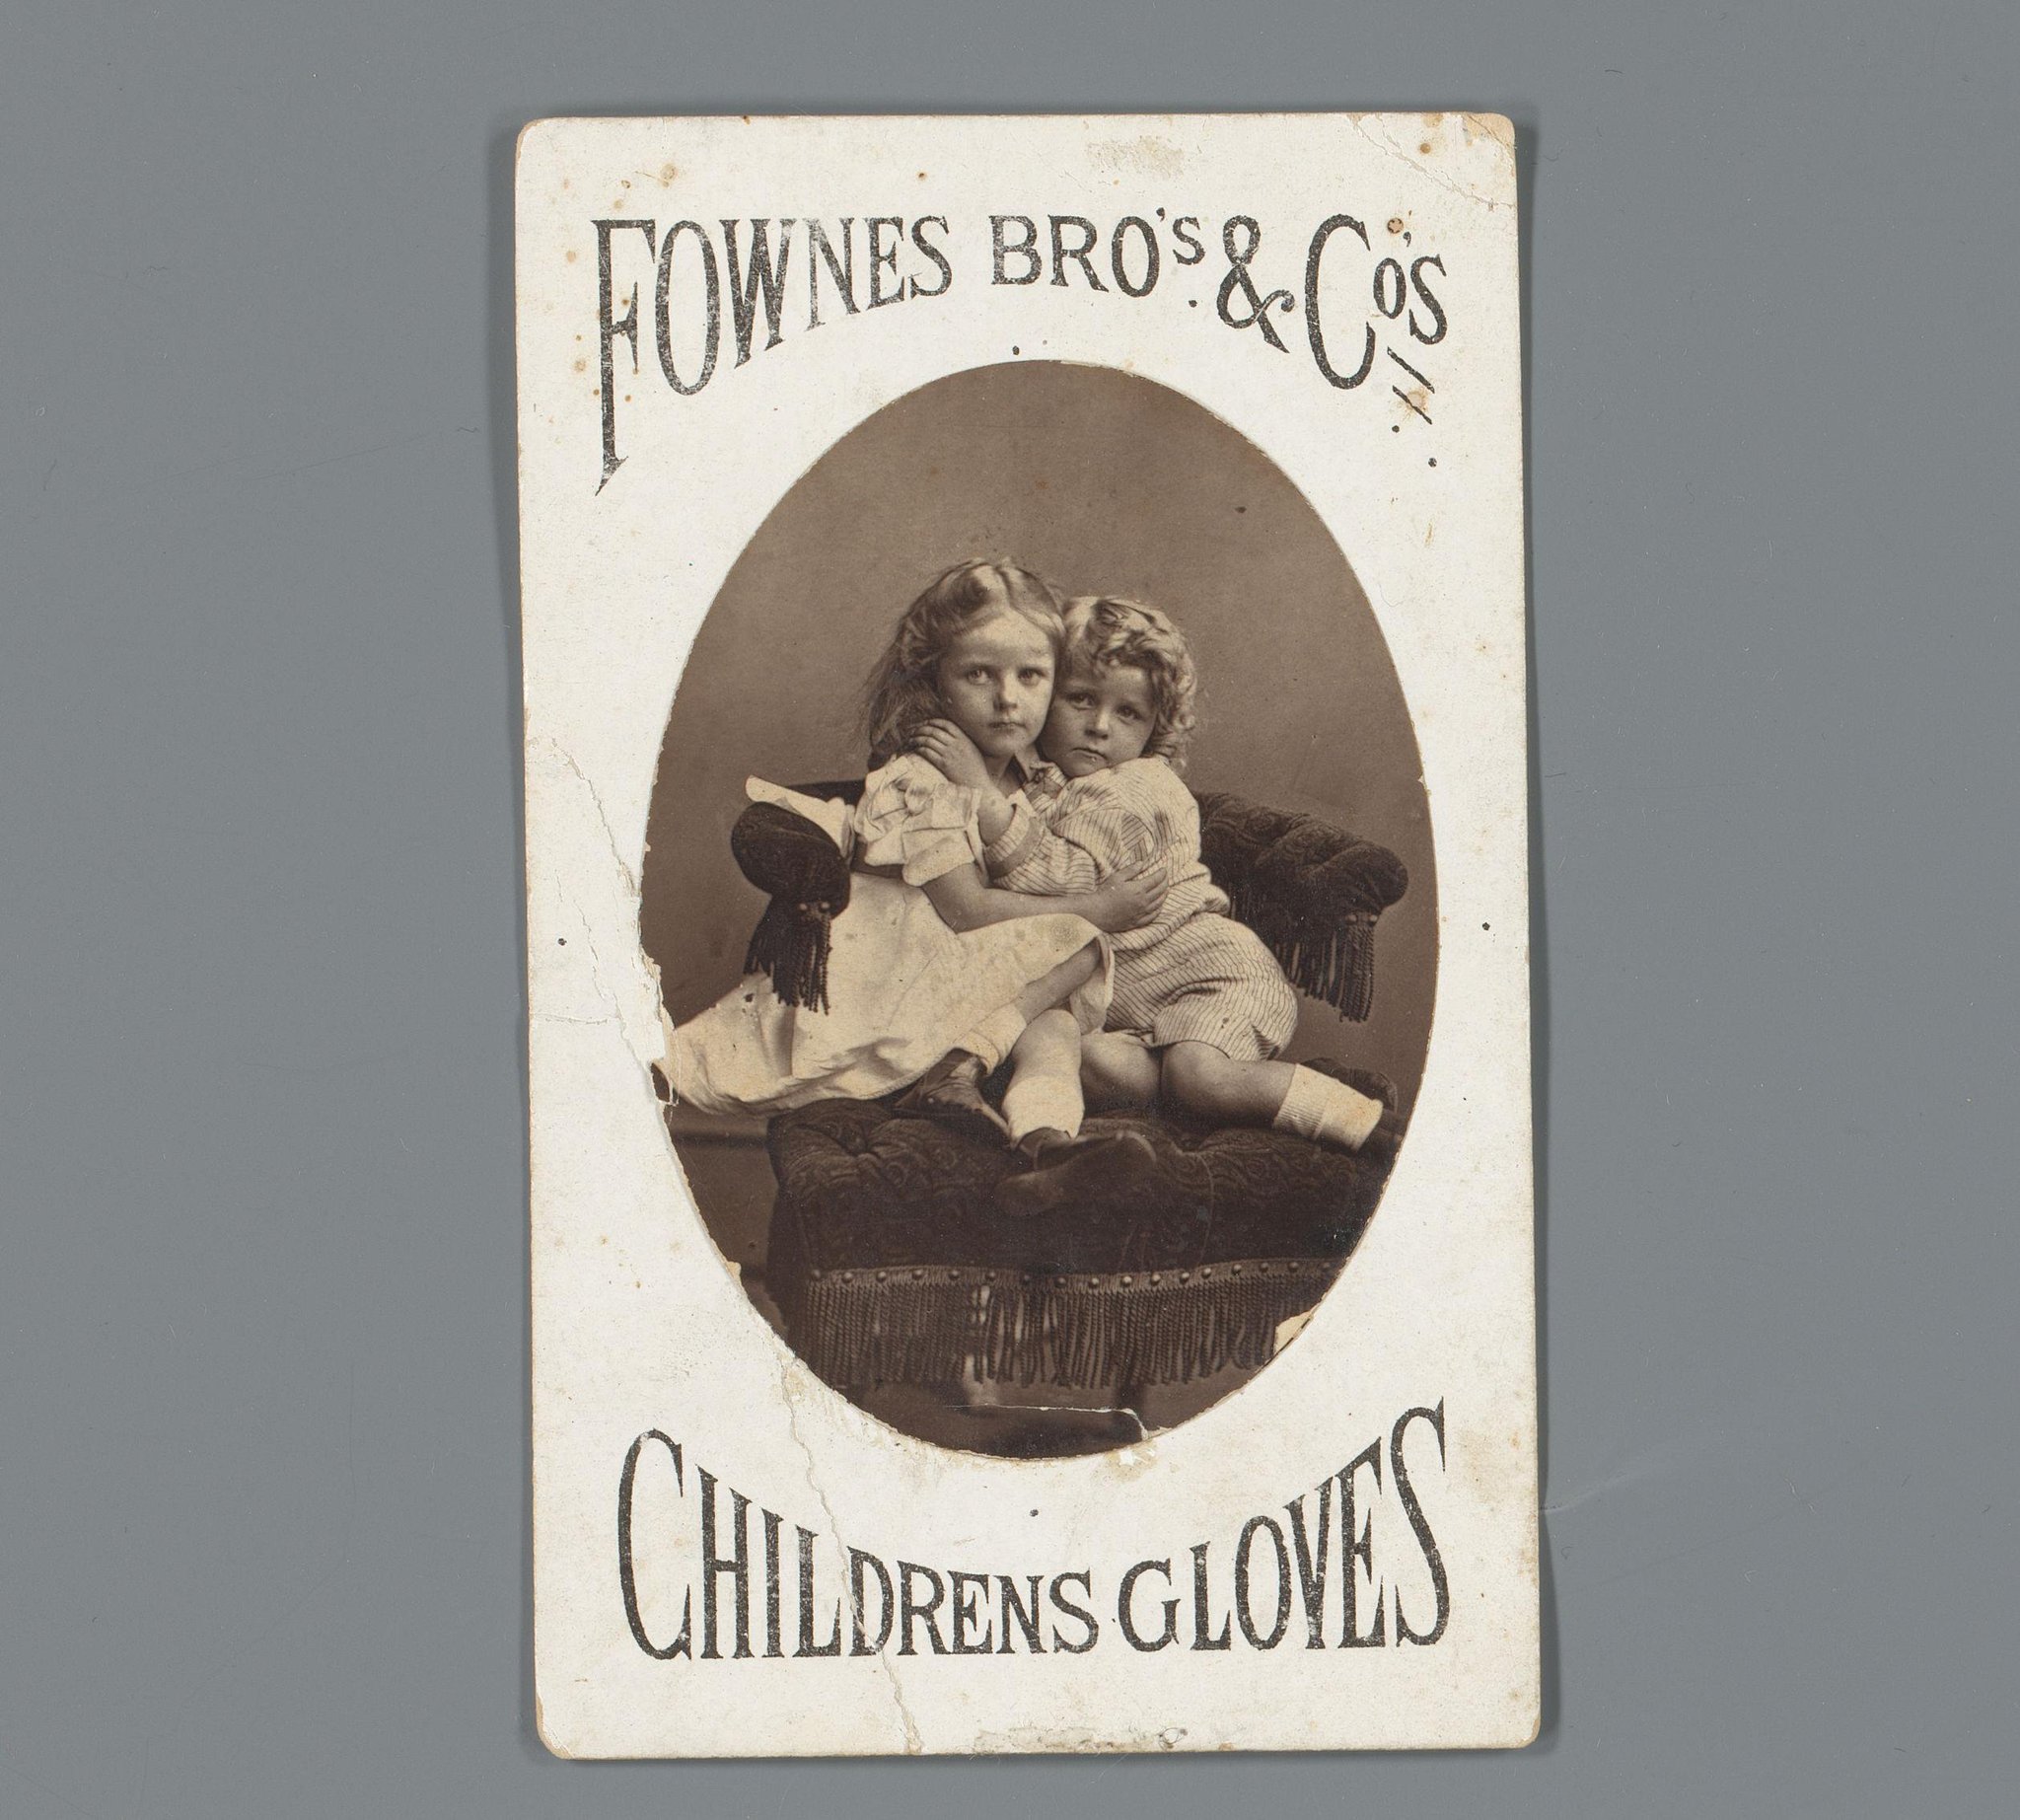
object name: photograph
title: Portret van twee kinderen als reclame voor kinderhandschoenen van Fownes Brothers & Cos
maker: Anonymous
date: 1860-1940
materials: cardboard, photographic support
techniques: carbon print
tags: advertising, gloves, mittens, etc., child, embracing each other, kissing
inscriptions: inscription: ‘FOWNES BRO'S & COS/ CHILDRENS GLOVES’